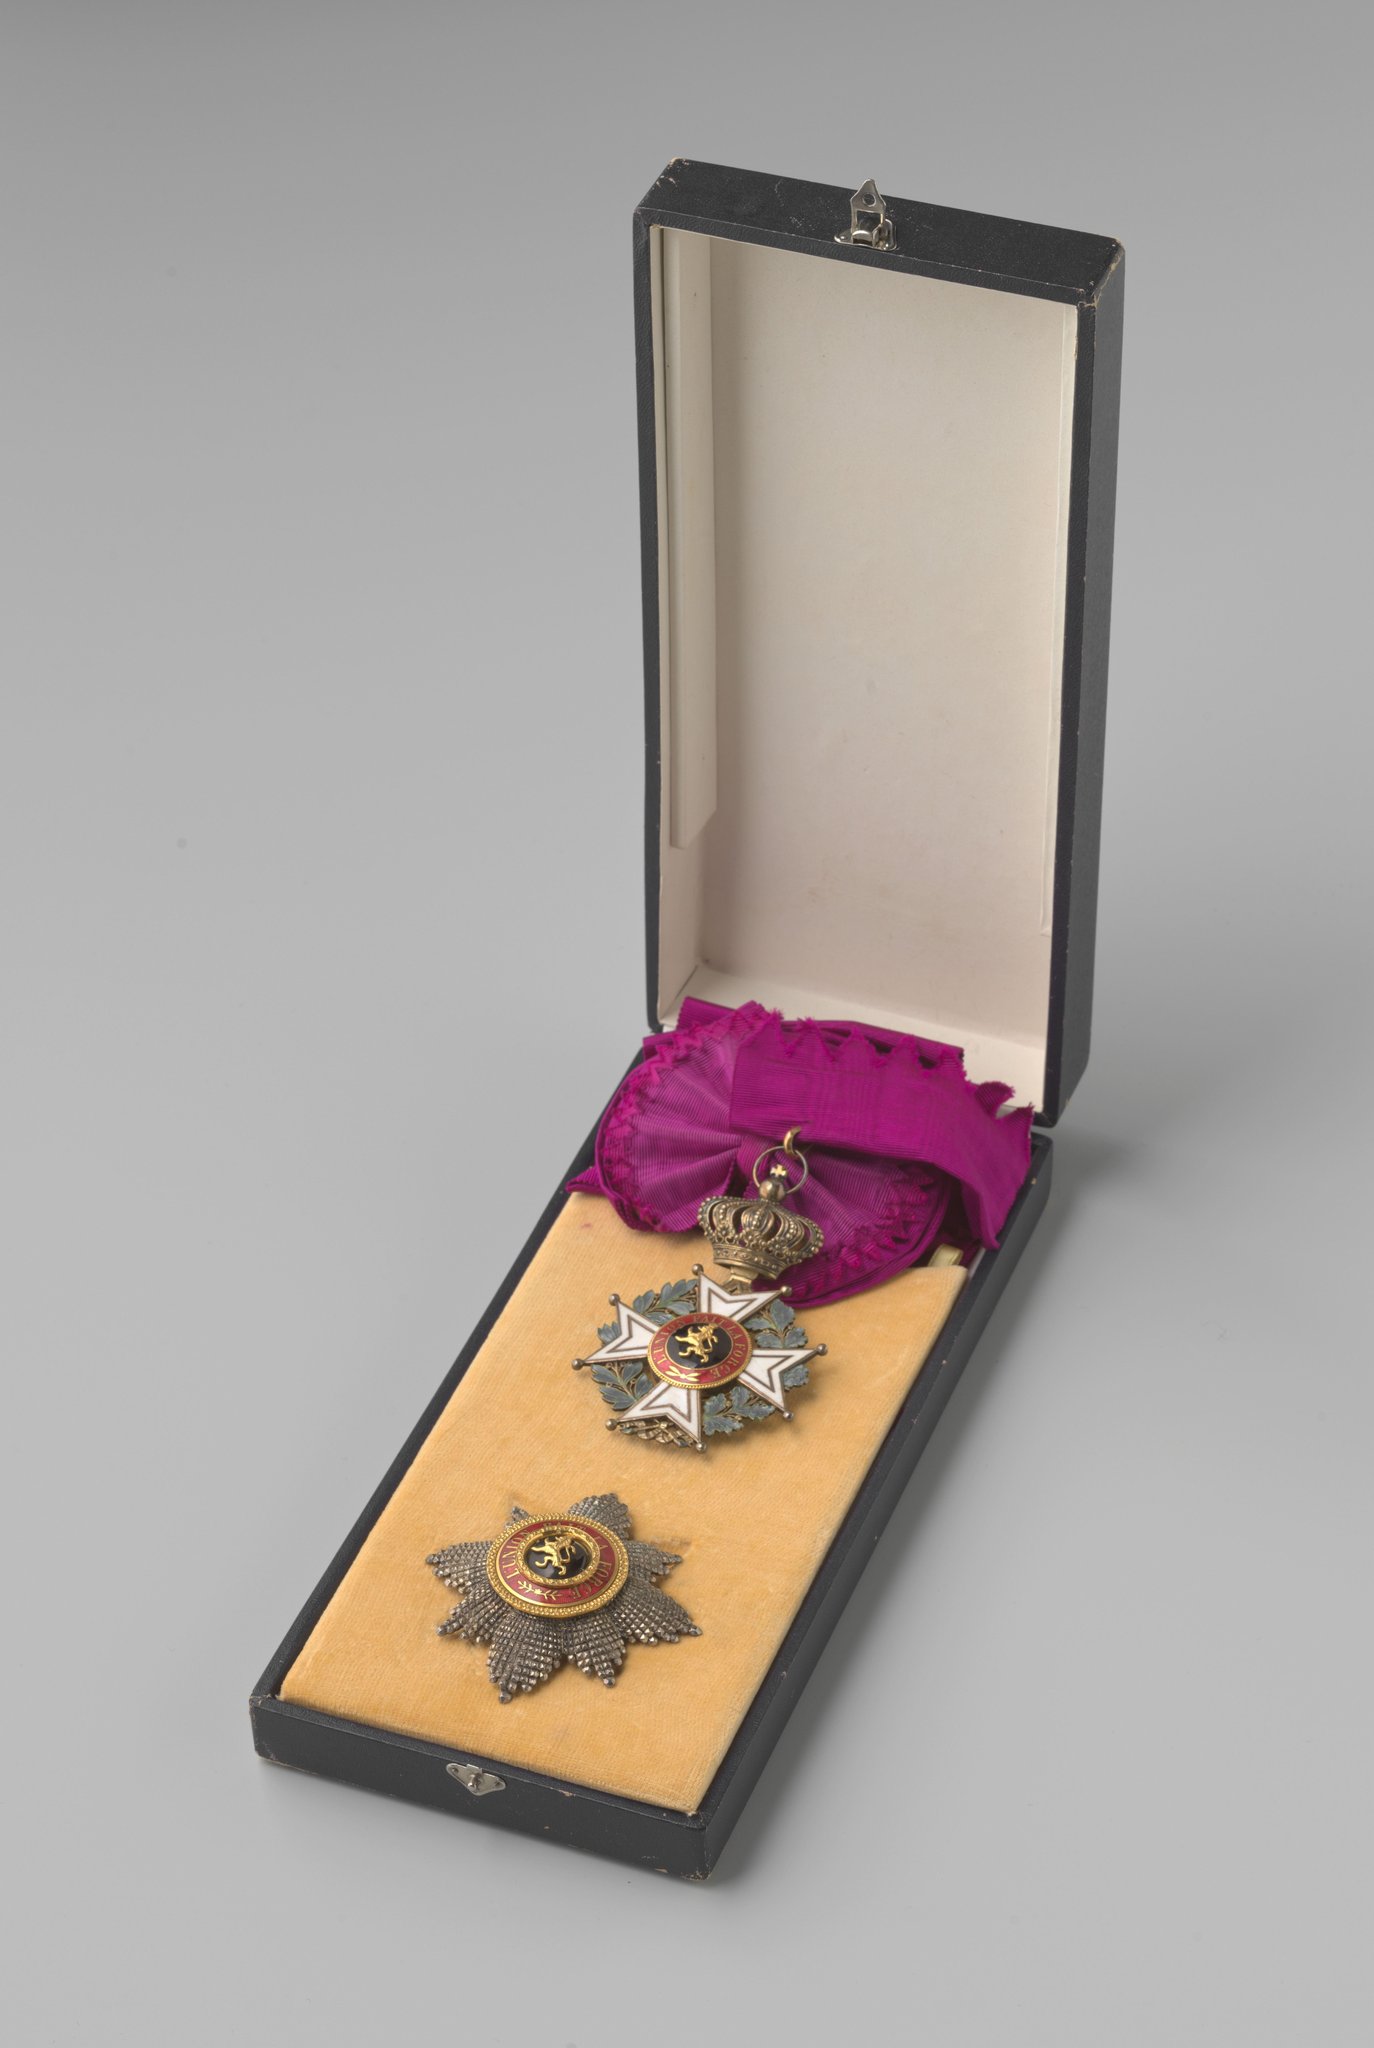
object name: ordeteken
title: Belgische ridderorde (Leopoldsorde), ontvangen door Willem Drees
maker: Anonymous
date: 1950-1960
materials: gold, silver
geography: brussels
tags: amsterdam, the hague, willem drees, netherlands, belgium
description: De zilveren ordester heeft acht gebrillianteerde punten, met het middenmedaillon met leeuw en omschrift, gelijk aan de voorzijde van het ordeteken, hier nog omringd met een gebrillianteerde gouden rand. De deksel is aan de binnenzijde met wit zijde gevoerd, de versierselen liggen op een geel fluwelen verhoging, waaronder de schouderband ligt.